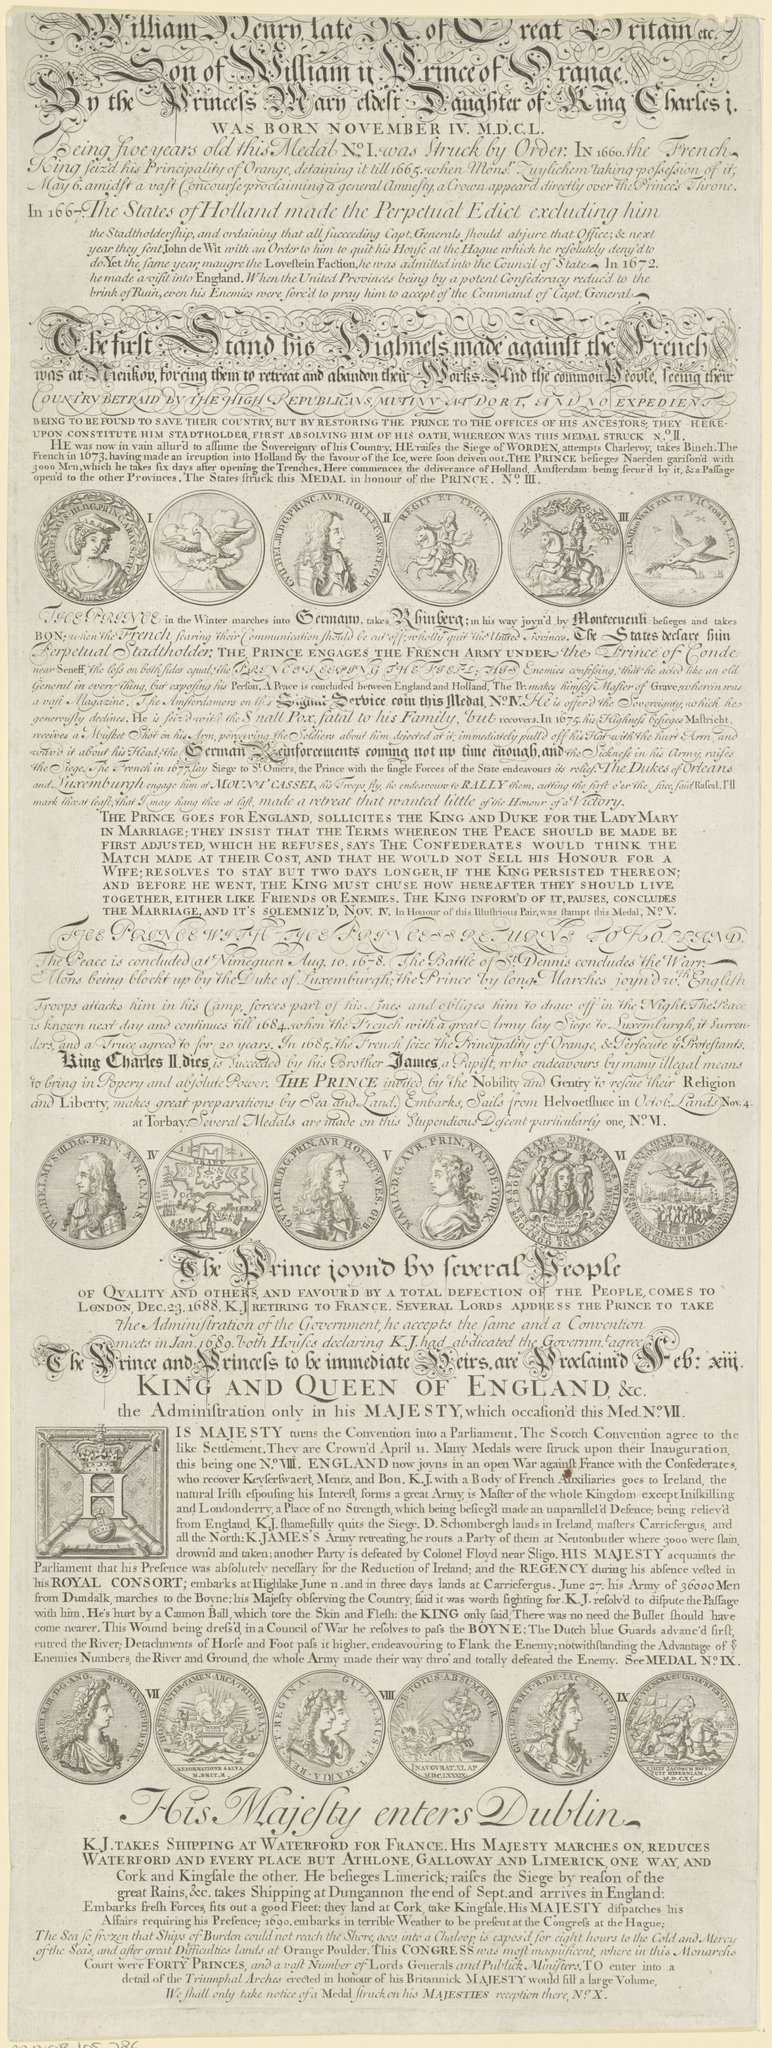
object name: print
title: Penningen met portretten van Willem III, prins van Oranje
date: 1700-1799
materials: paper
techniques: engraving, etching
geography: london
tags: william iii (prince of orange and king of england, scotland, and ireland)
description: De hier vermelde titel verwijst naar de hoogst verkregen titel van de geportretteerde, niet per se naar de titel die de geportretteerde op deze voorstelling draagt.